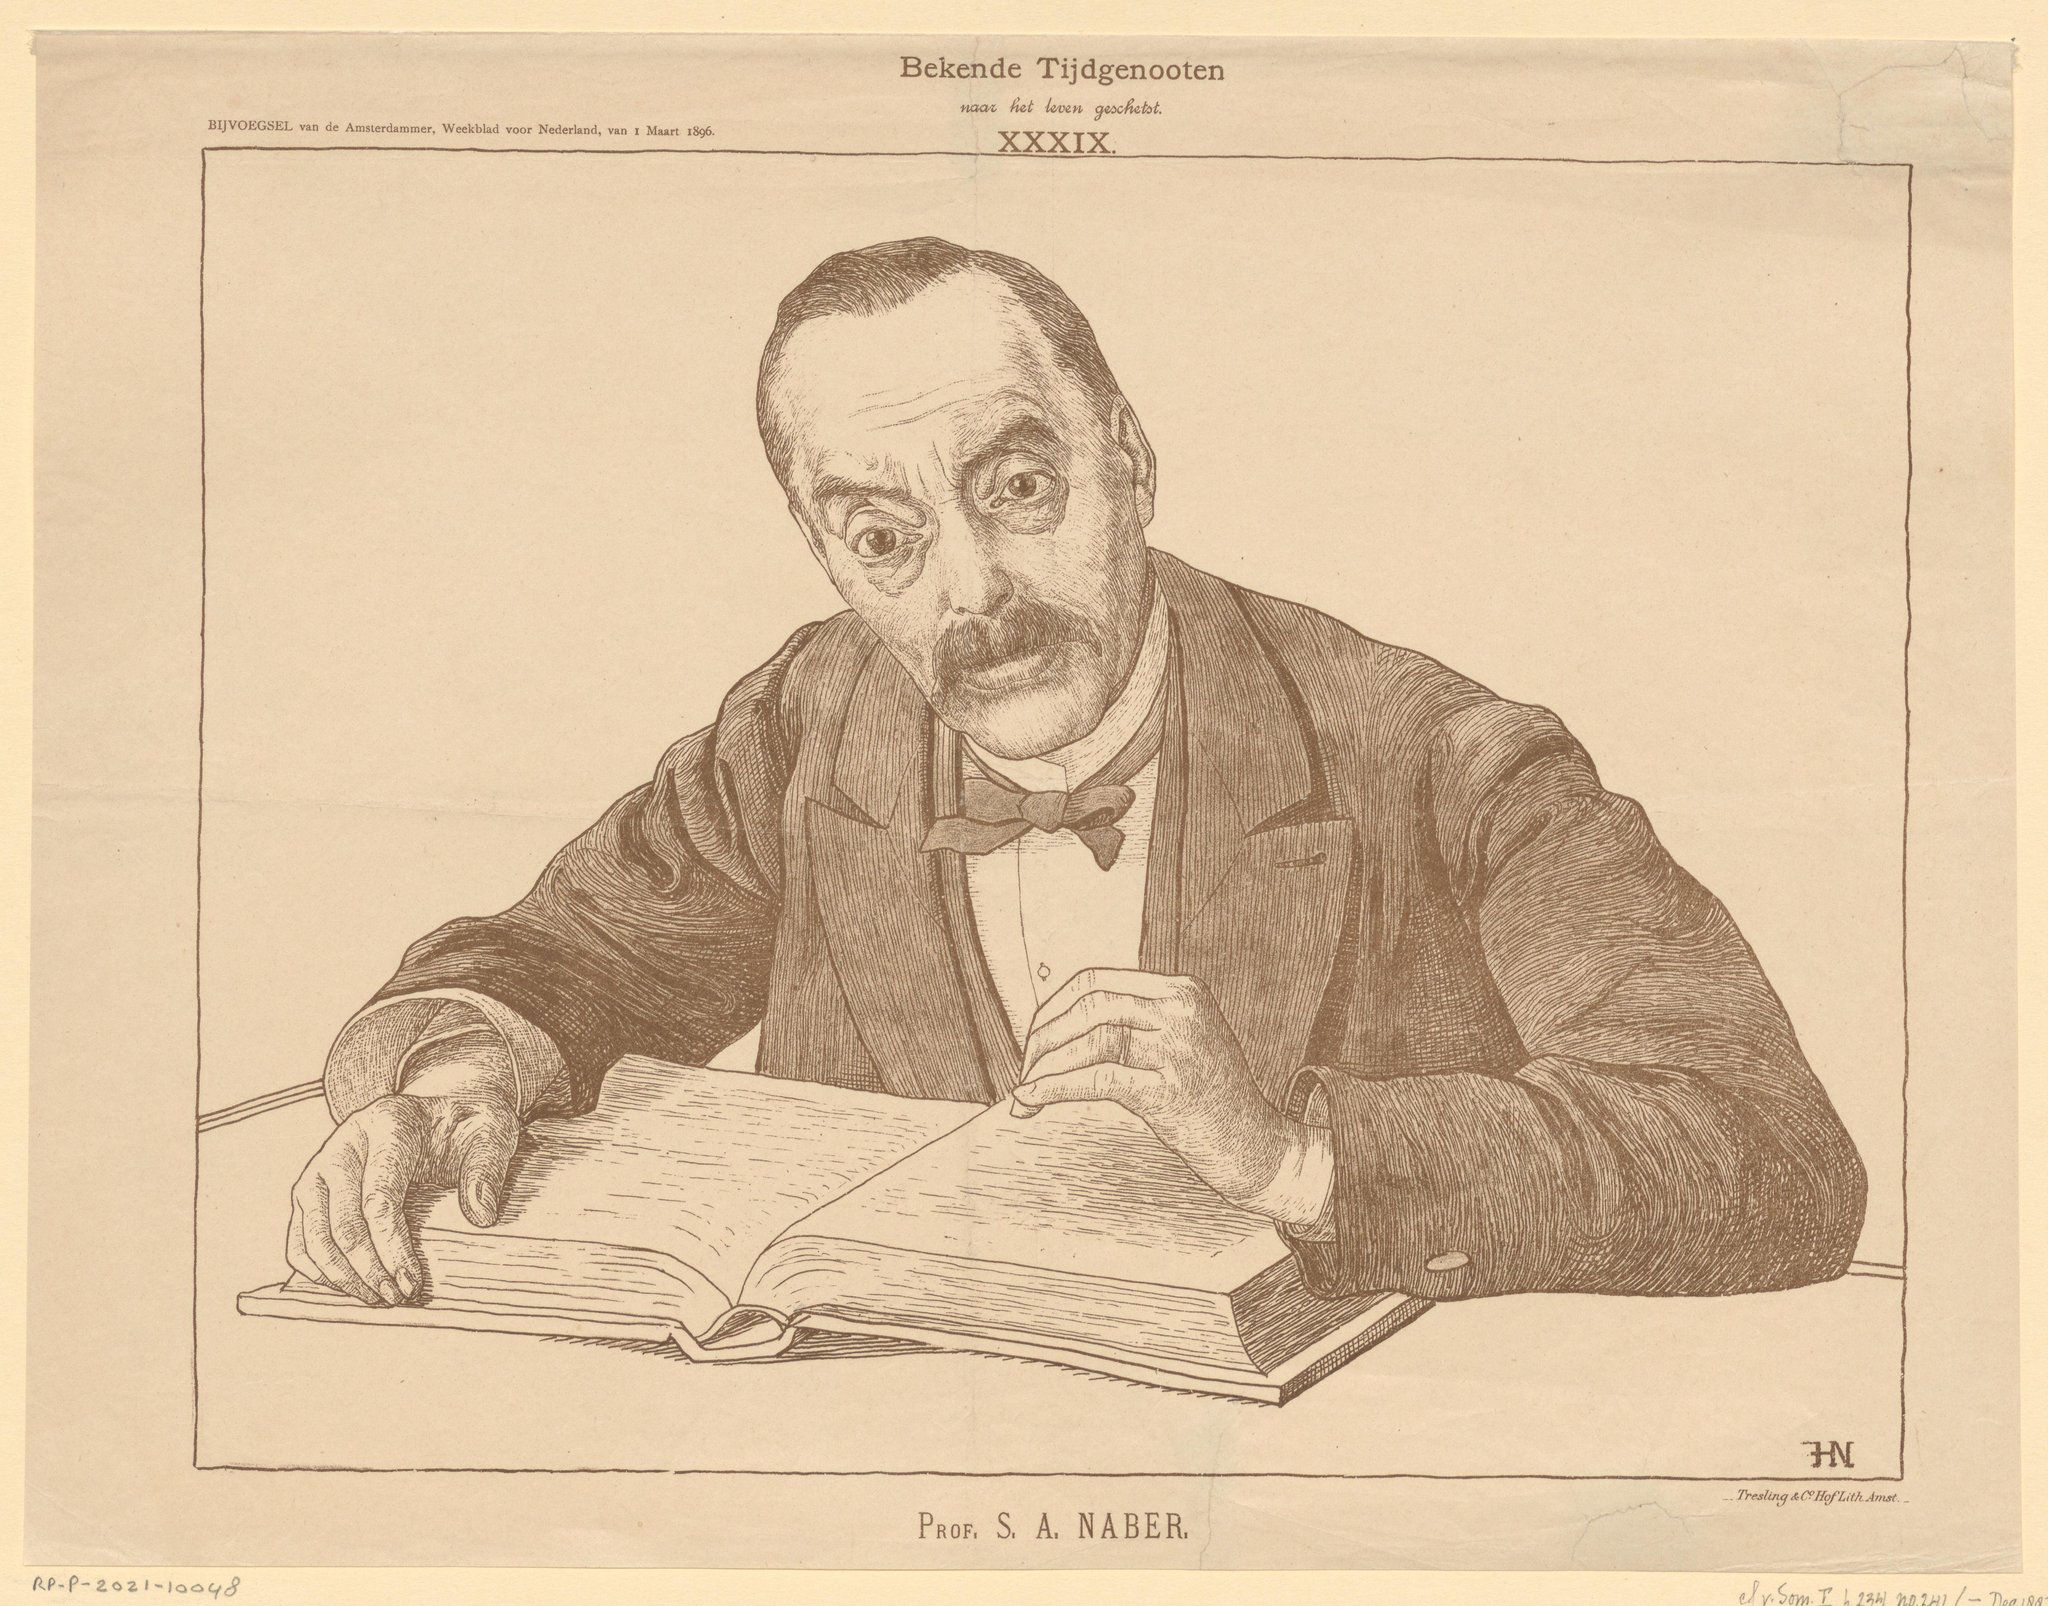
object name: print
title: Bekende tijdgenooten naar het leven geschetst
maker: ferdinand hart nibbrig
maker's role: draughtsman, painter, print maker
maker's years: 1866-1915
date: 1896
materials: paper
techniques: lithograph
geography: amsterdam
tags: the hague, amsterdam, historical persons, professor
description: Prent is verschenen als bijvoegsel van: De Amsterdammer. Weekblad voor Nederland (1896), nr. 975, 1 maart 1896.